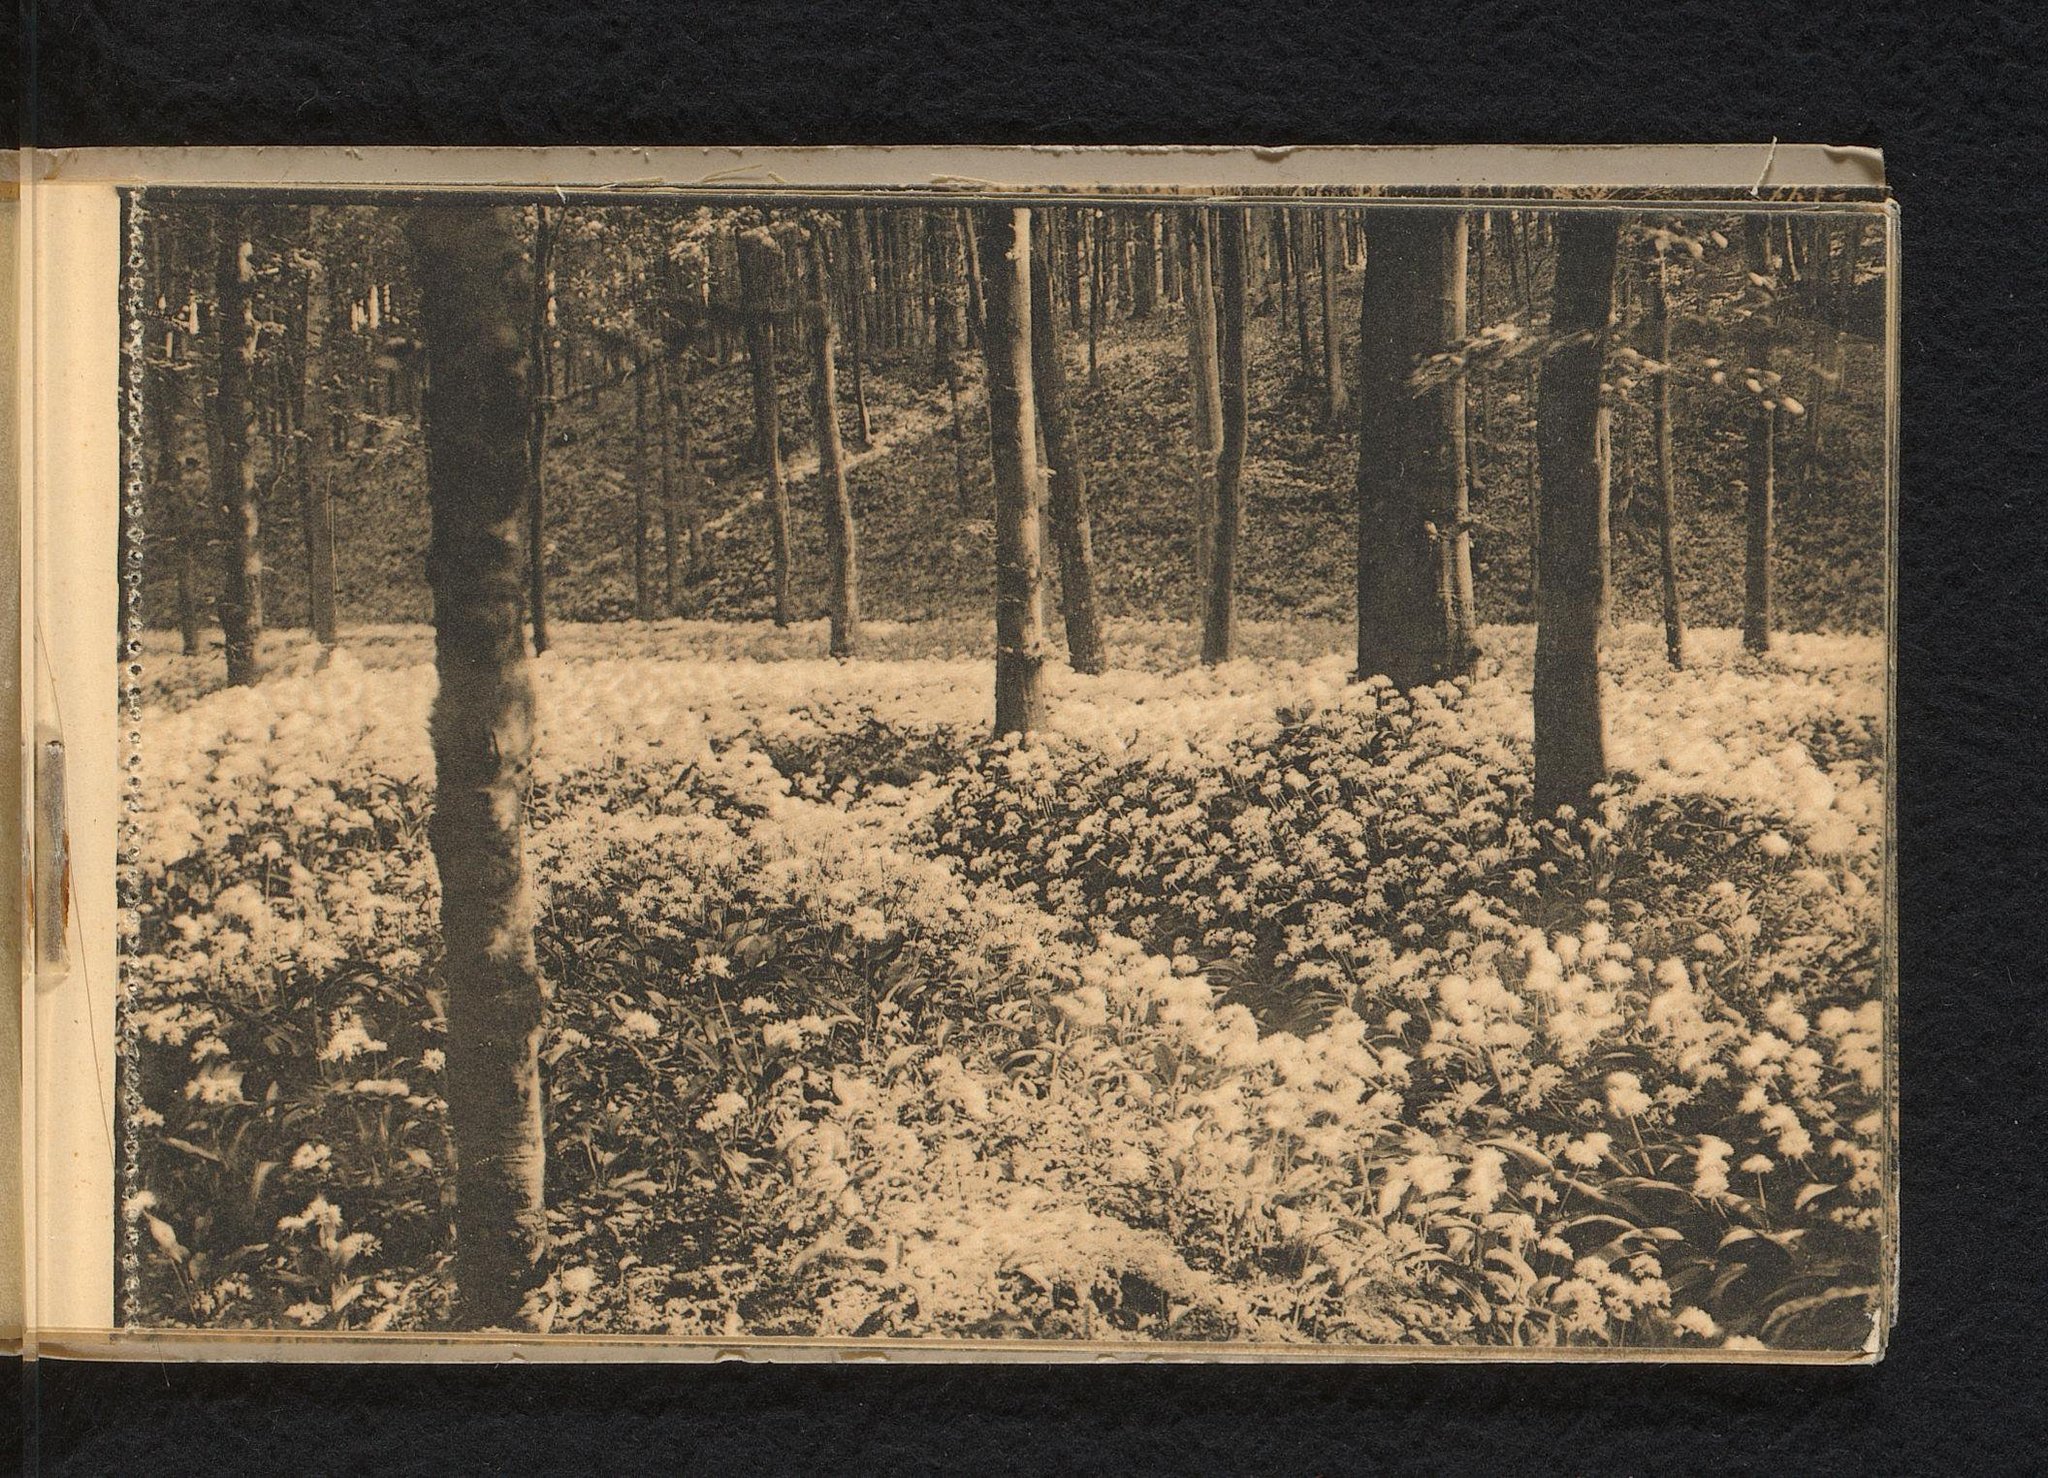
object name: photomechanical print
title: Floraison de l'Ail des Ours (vallon des Ails)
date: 1909-1914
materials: cardboard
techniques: photograph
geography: zoniënwoud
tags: flowers, forest, wood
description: Prentbriefkaart maakt deel uit van een album.